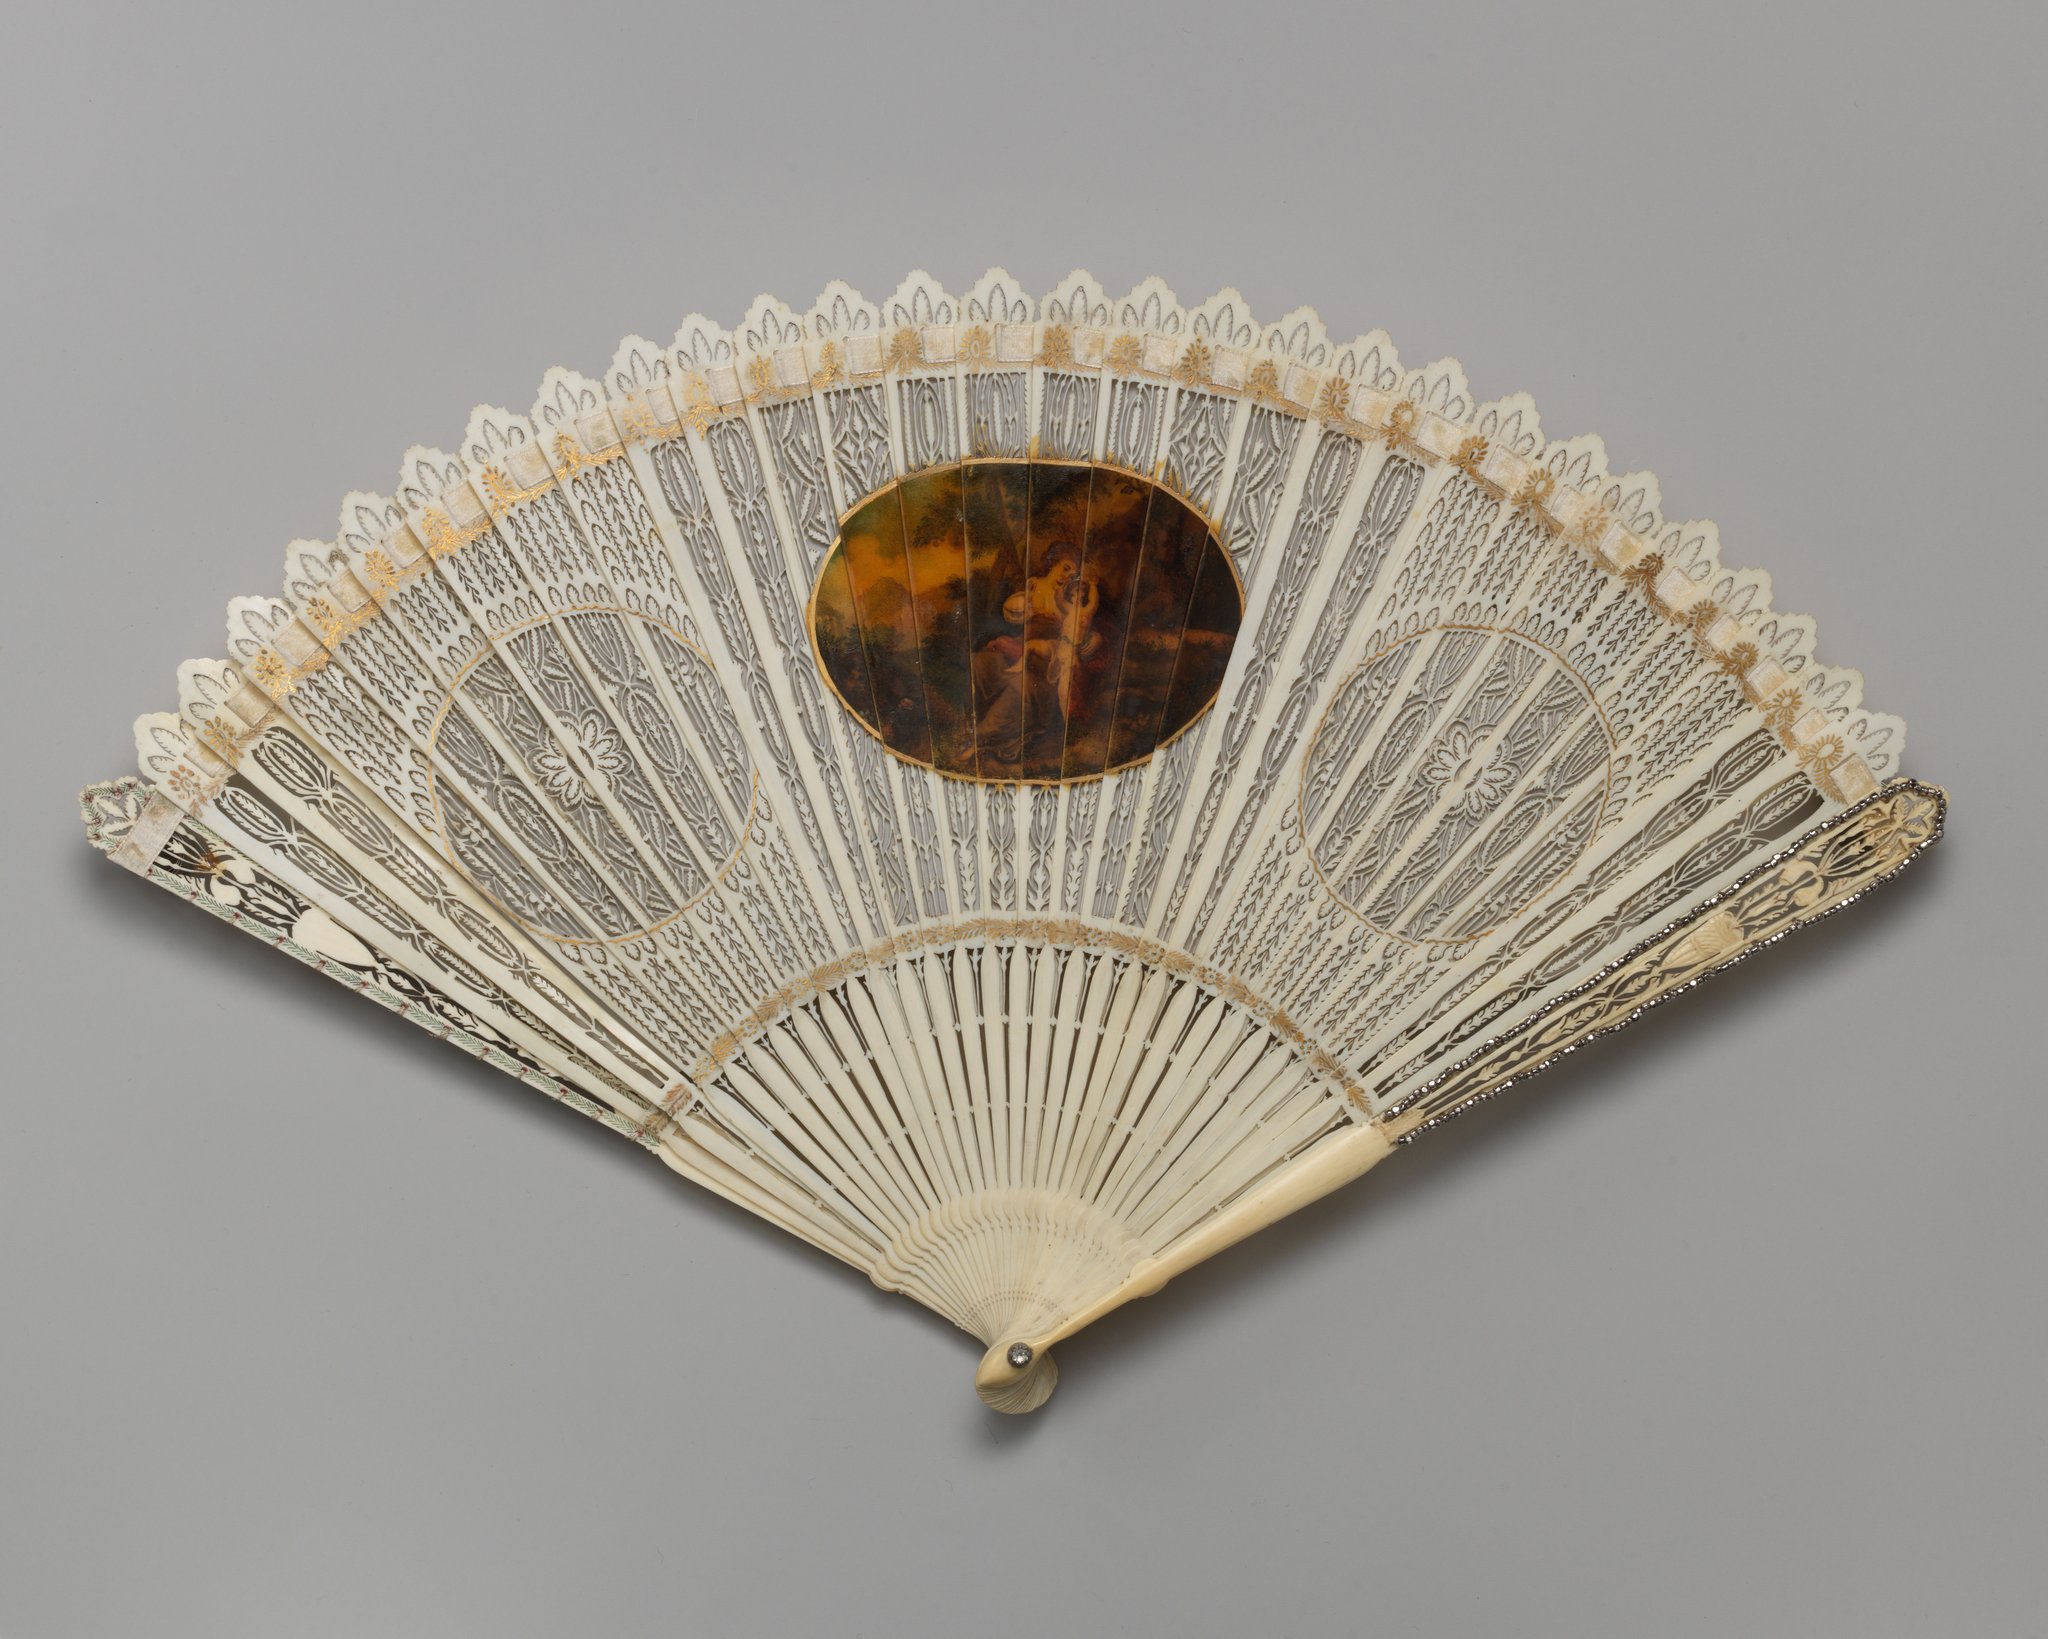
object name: fan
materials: ivory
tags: children,women